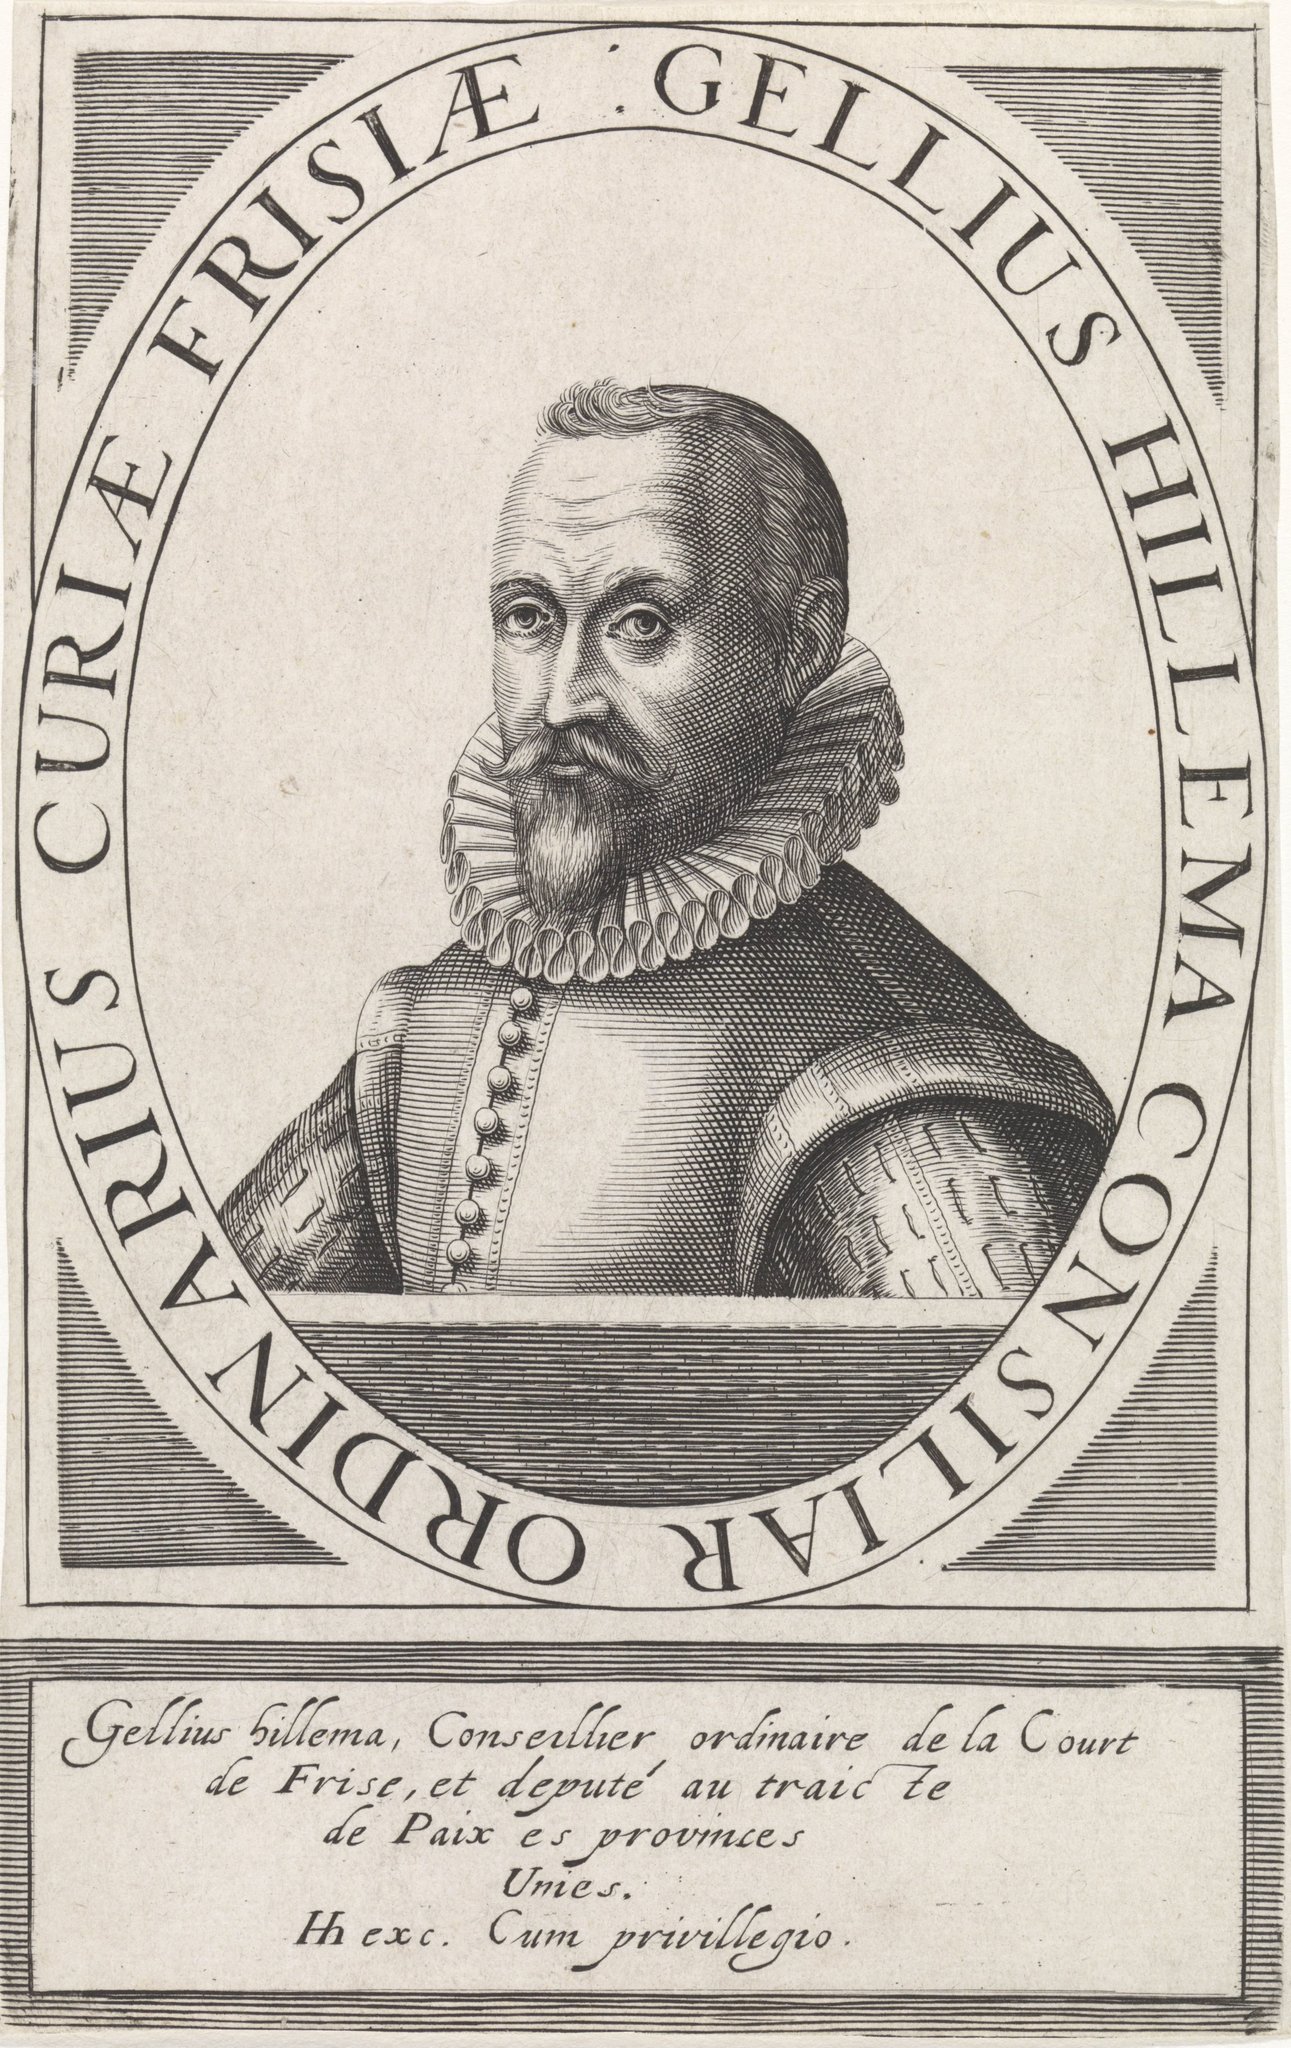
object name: print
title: Portret van Gellius Hillema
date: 1608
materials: paper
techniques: engraving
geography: the hague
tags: gellius hillema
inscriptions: collector's mark: Lugt 2228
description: Buste naar links van Gellius Hillema, in een ovale omlijsting, waarop een randschrift met zijn naam en titel in het Latijn. Onder het portret vier regels in het Frans. Prent uit een serie van veertig portretten van vredestichters in de Nederlanden.